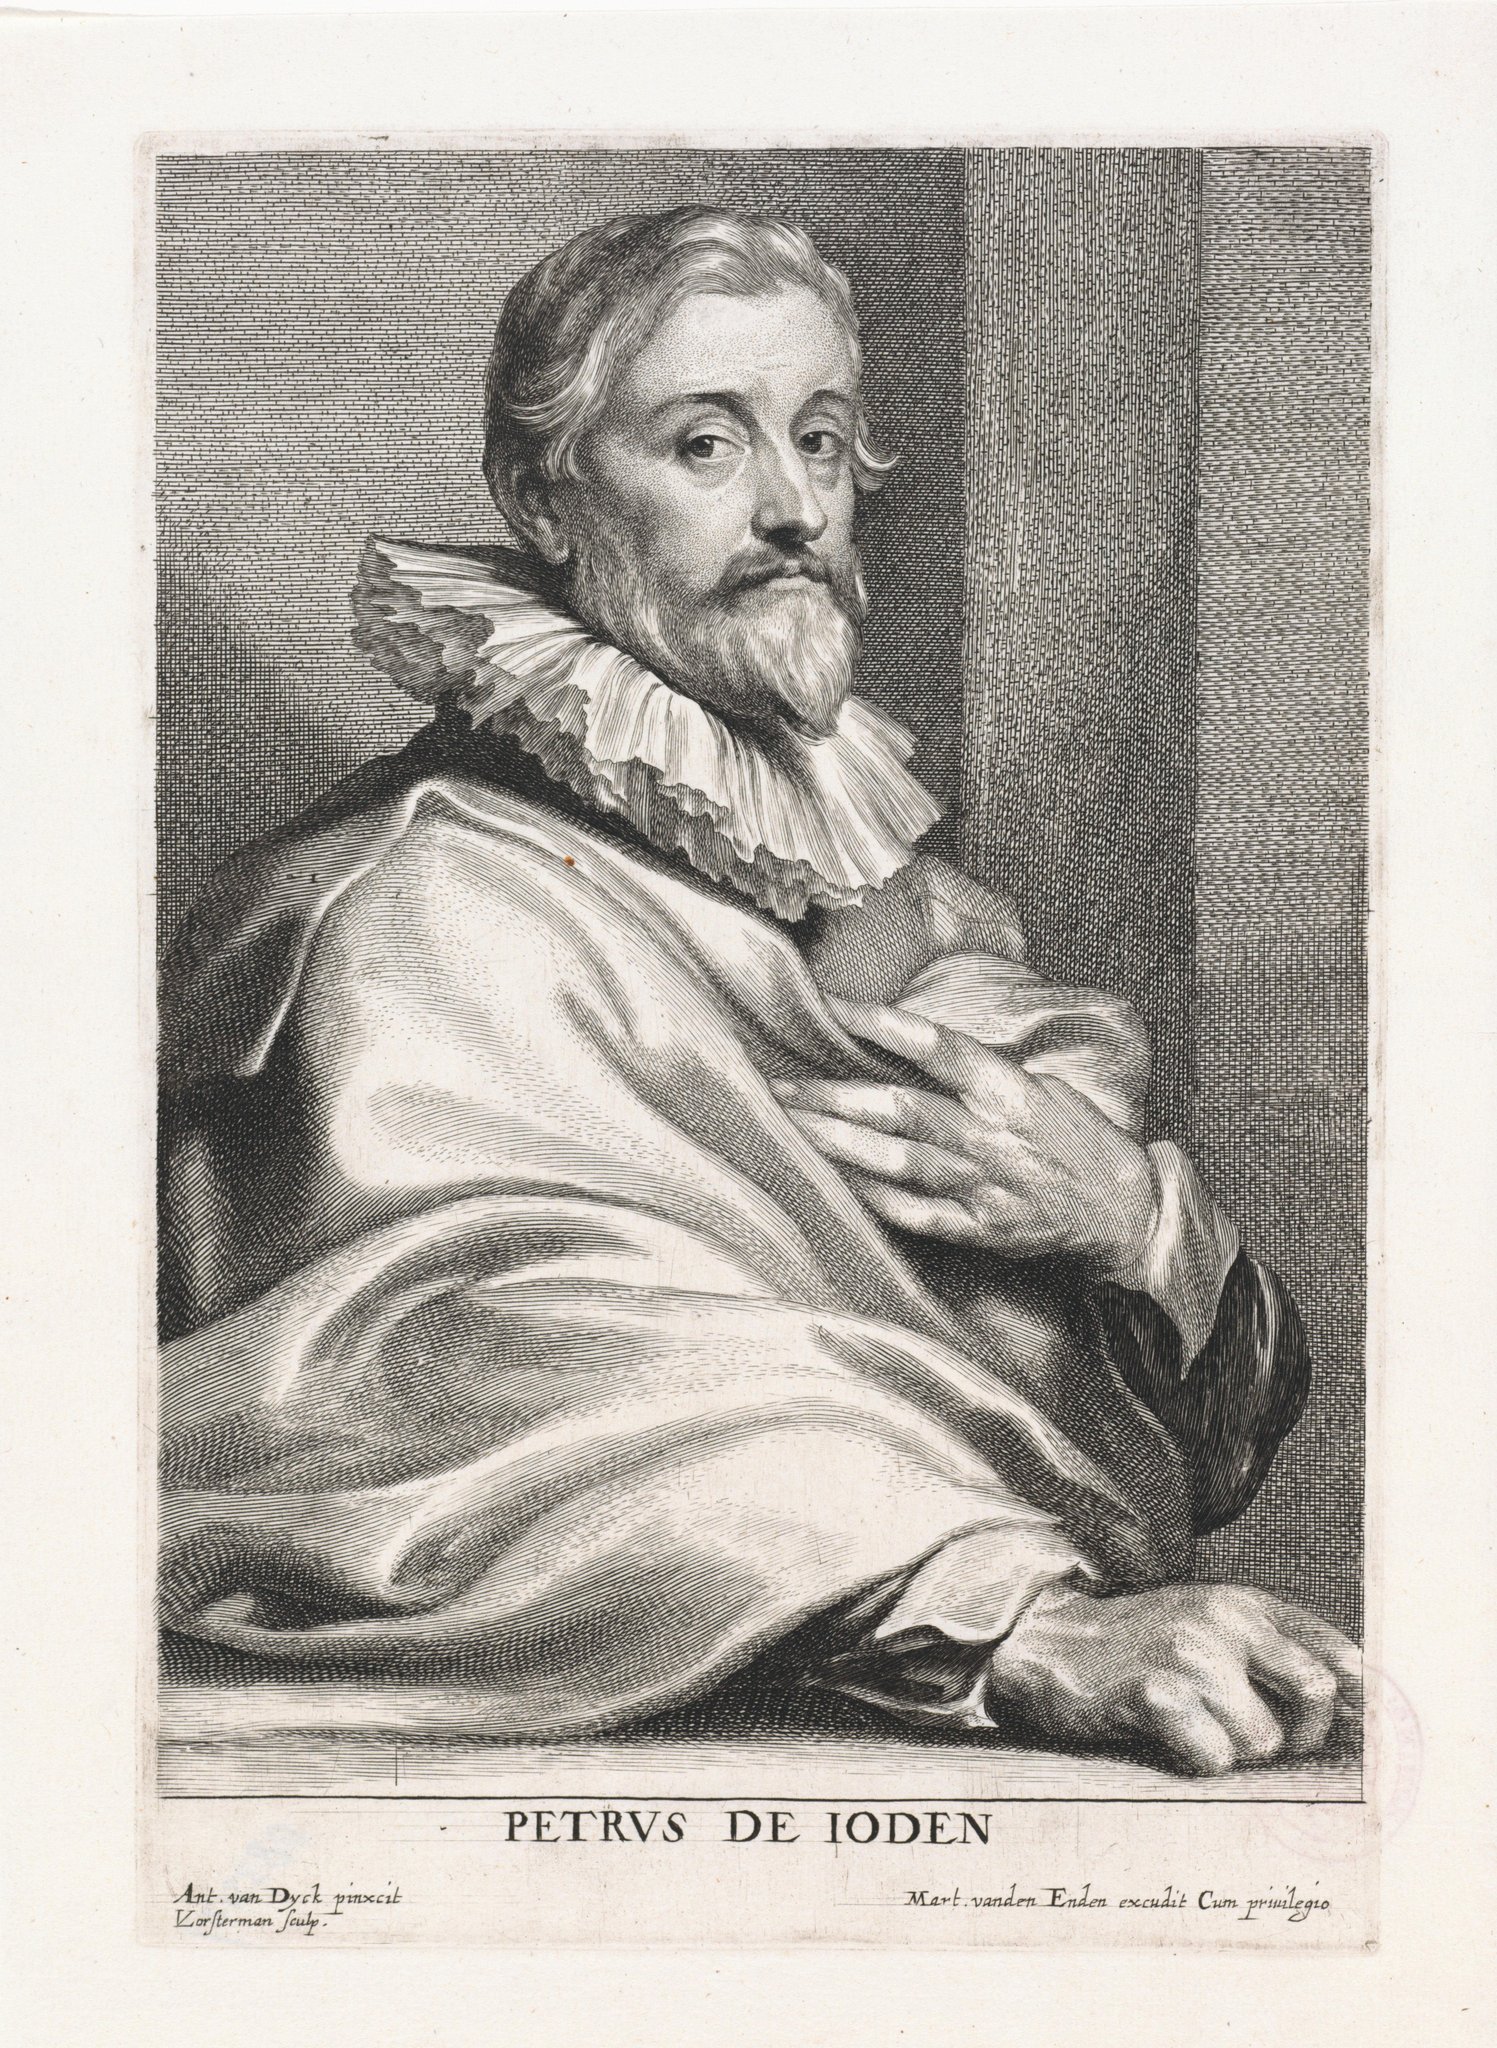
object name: print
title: Portret van Pieter de Jode (I)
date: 1630-1646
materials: paper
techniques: engraving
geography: antwerp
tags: pieter de jode (i)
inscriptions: collector's mark: Lugt 240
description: Prent gebruikt voor: Icones principum, virorum doctorum, pictorum, chalcographorum, statuariorum nec non amatorum pictoriae artis numero centum ab Ant. van Dyck ad vivum expressae ejusque sumptibus aeri incisae. Antwerpen: Gillis Hendricx, [1645-1646].